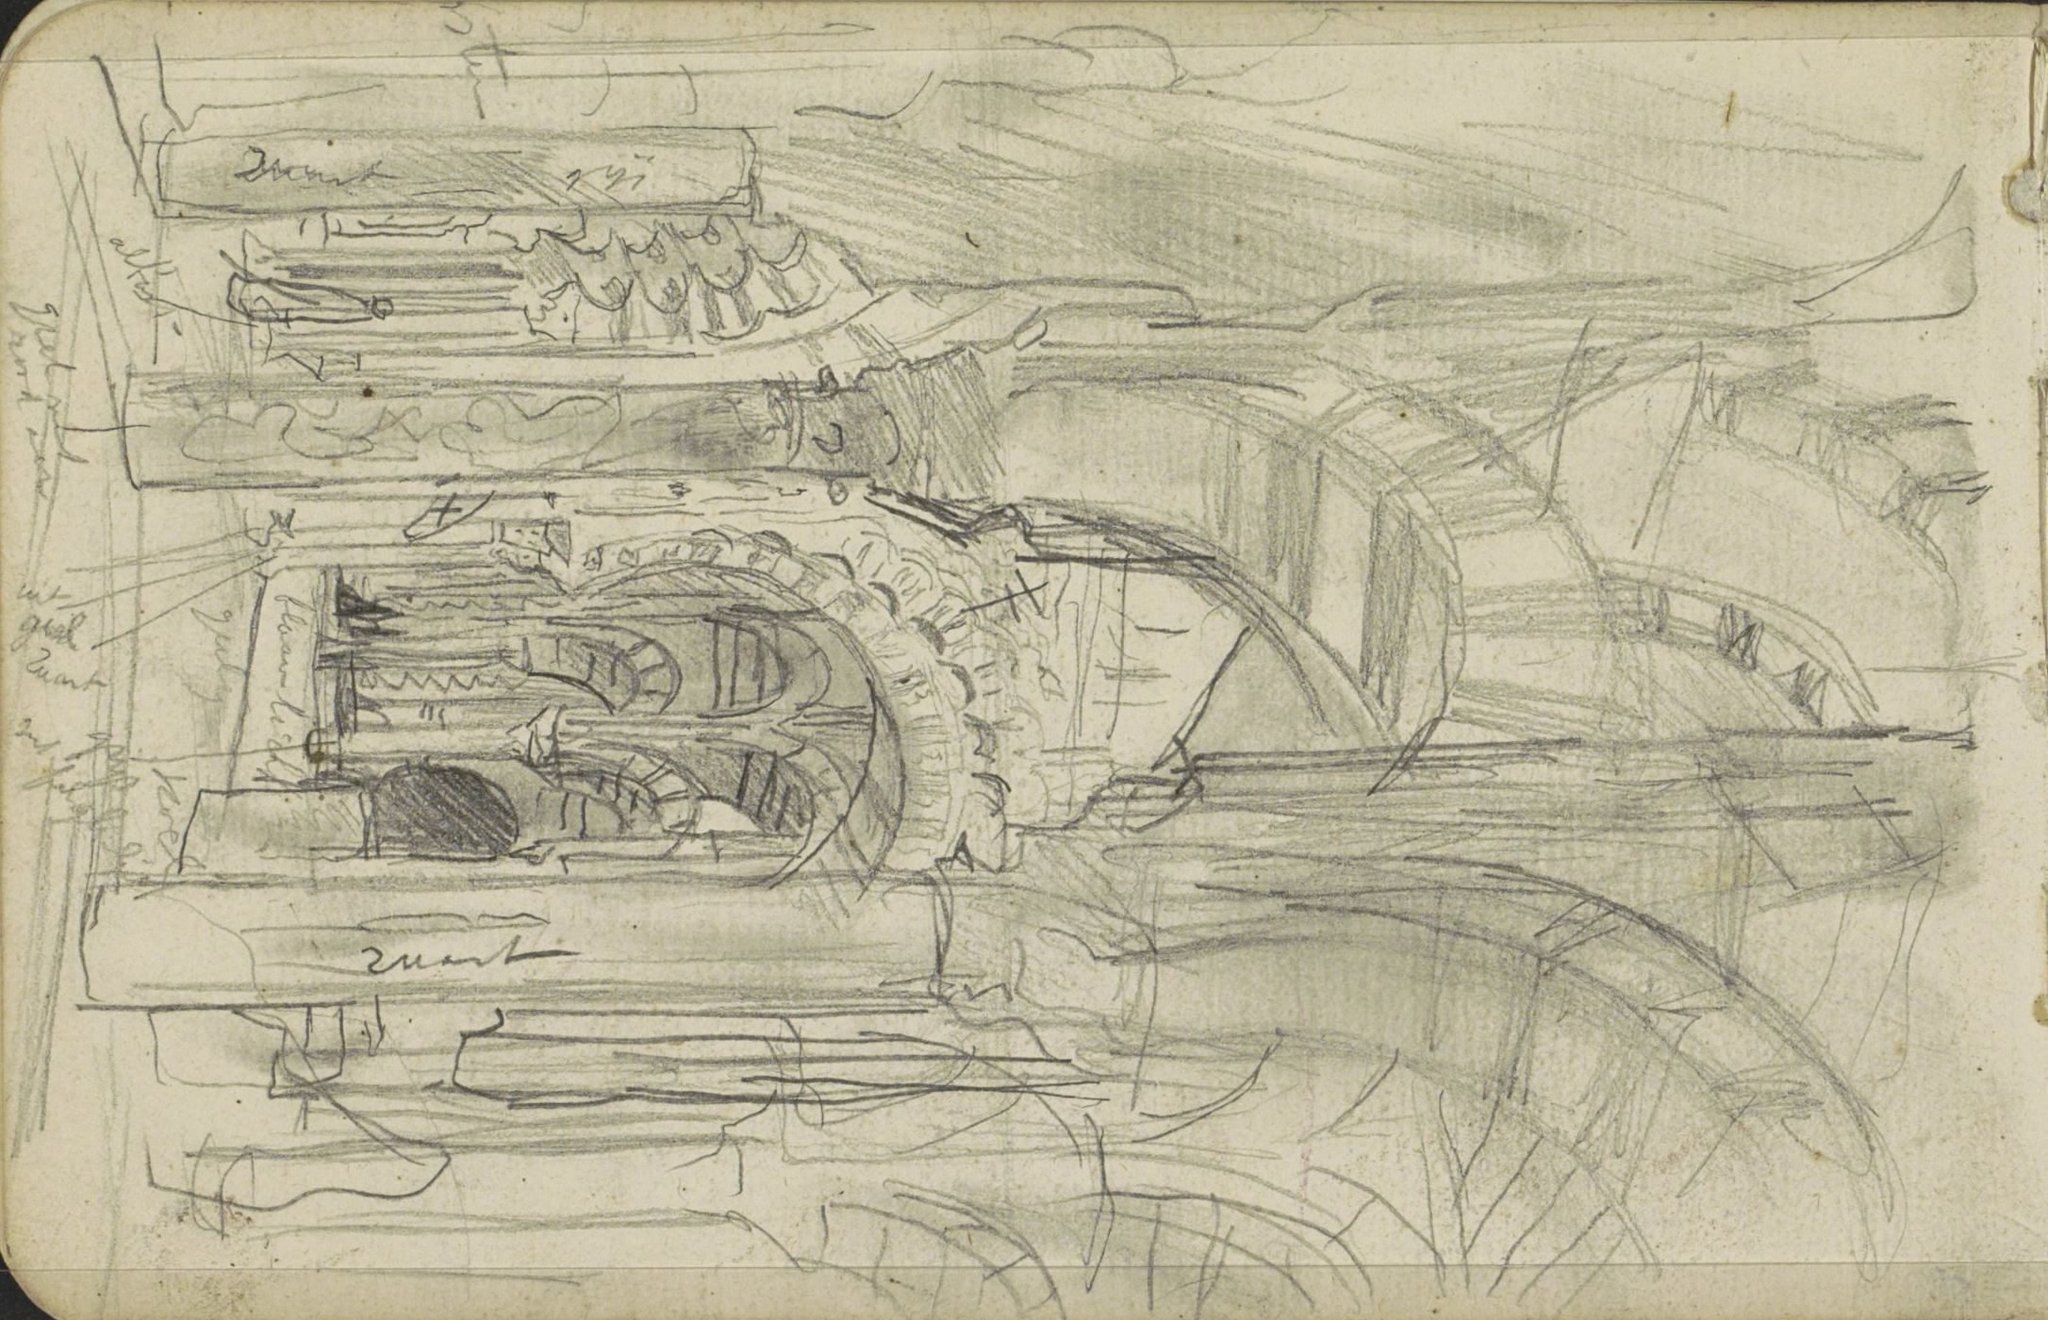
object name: sketchbook leaf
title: Interieur van de Mezquita kathedraal van Córdoba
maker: marius bauer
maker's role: draughtsman, print maker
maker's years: 1867-1932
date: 1902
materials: paper, pencil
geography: córdoba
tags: interior of church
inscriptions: kleurnotitie, handgeschreven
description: Pagina 6 uit een schetsboek met 30 bladen.